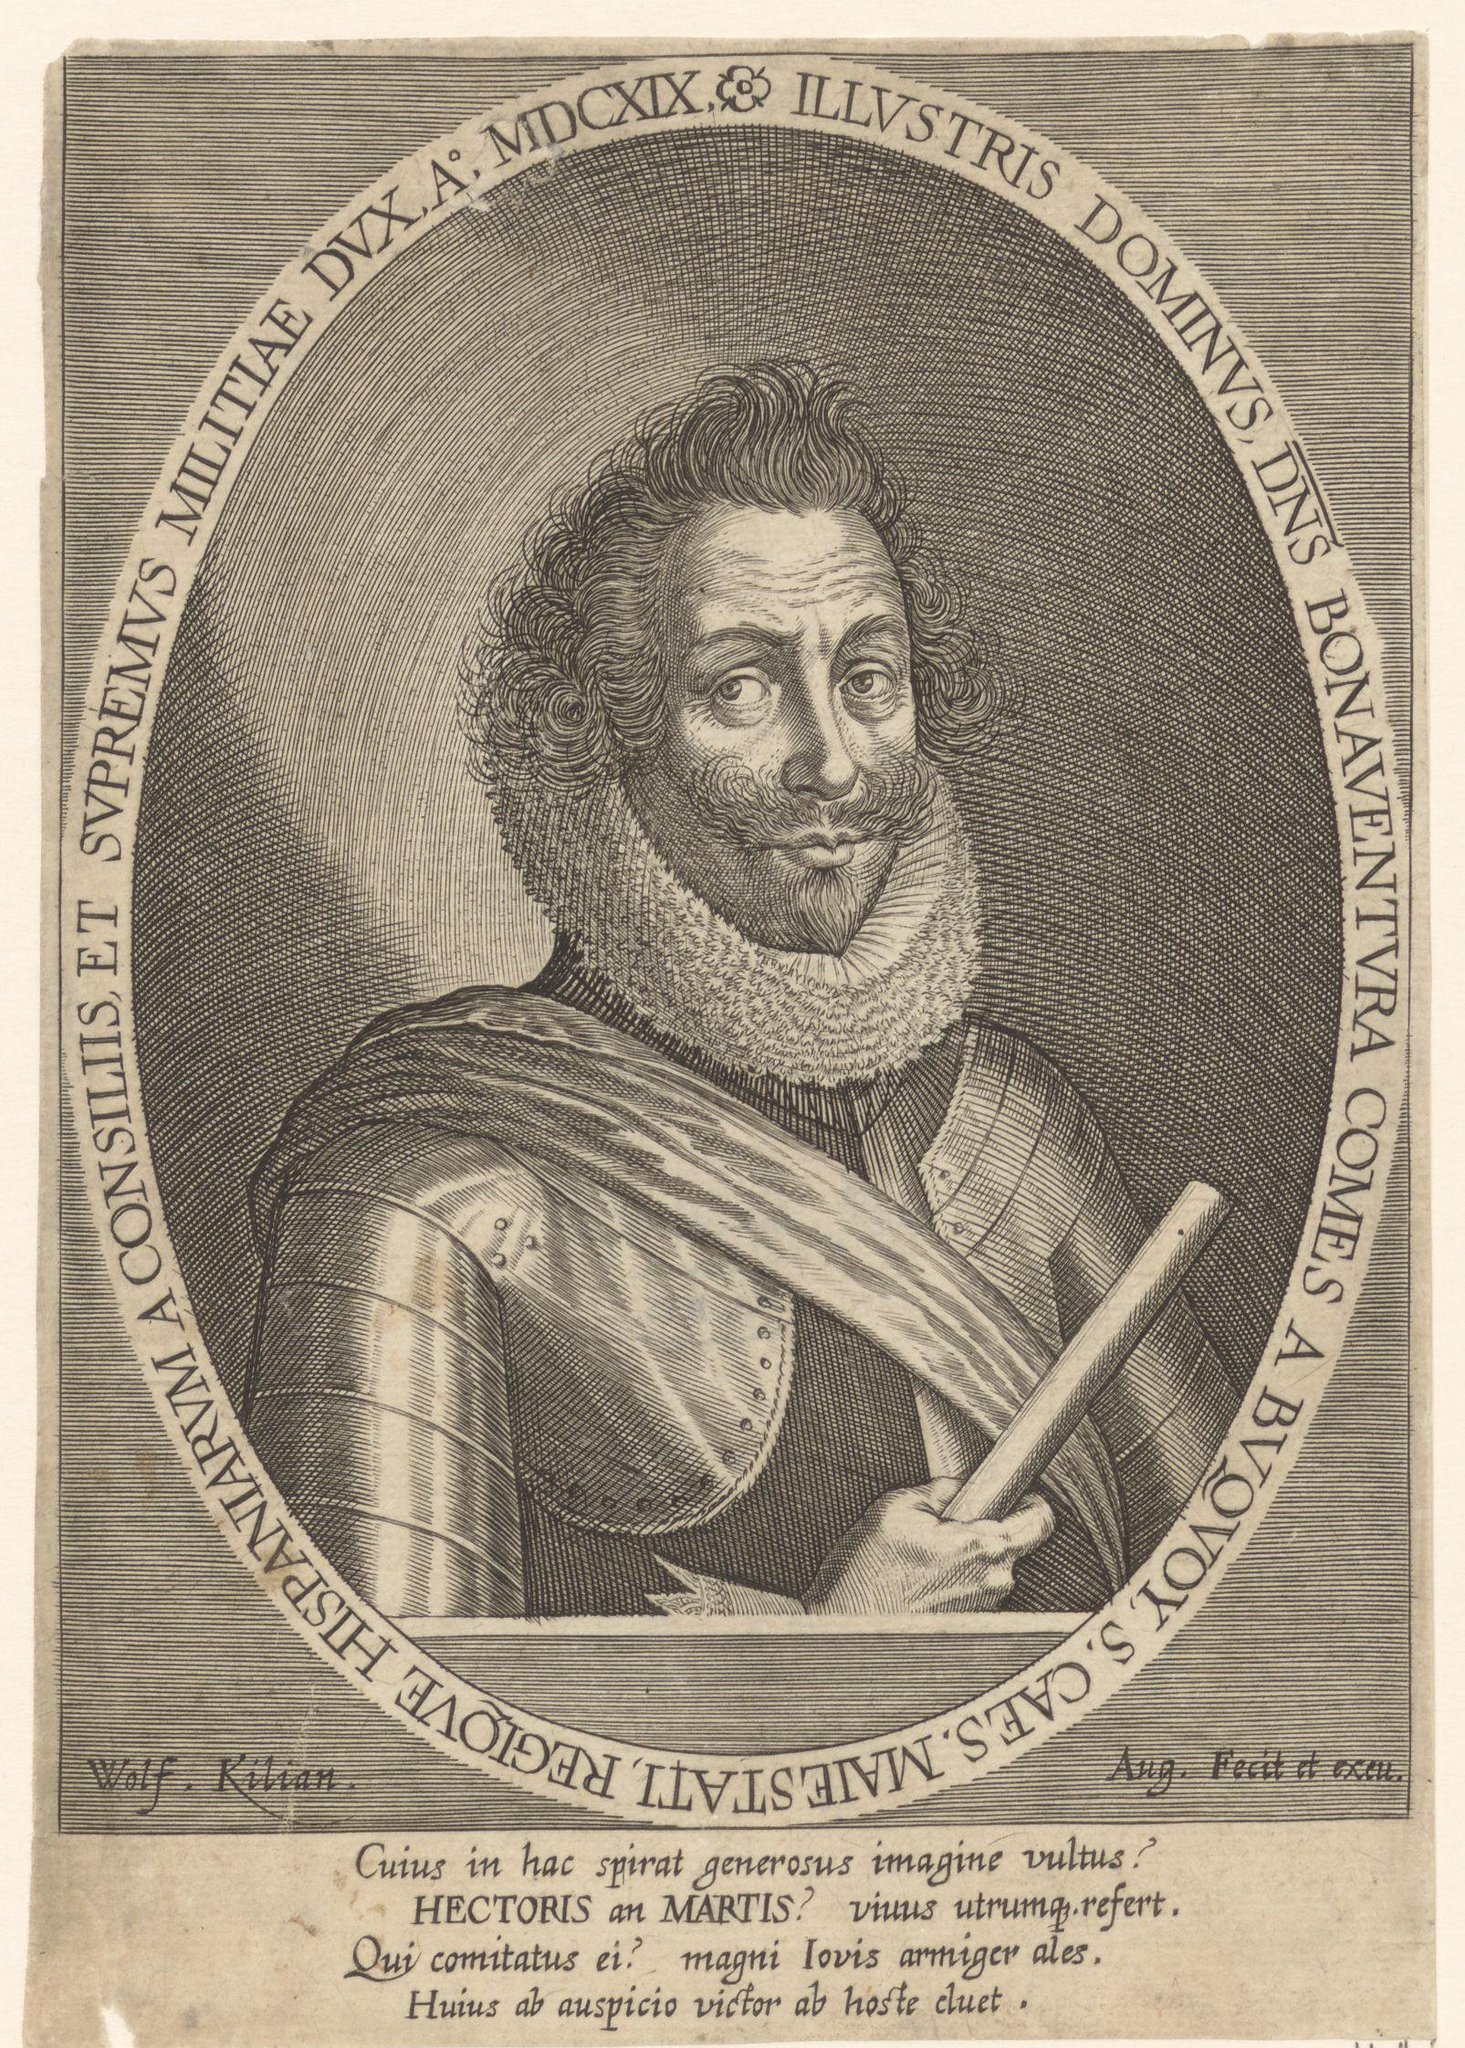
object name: print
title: Portret van Karl Bonaventura von Buquoy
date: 1619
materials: paper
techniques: engraving, etching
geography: augsburg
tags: commander-in-chief, general, marshal, historical persons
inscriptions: collector's mark: Lugt 2228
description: Tekst in het Latijn in de omlijsting en in de ondermarge.